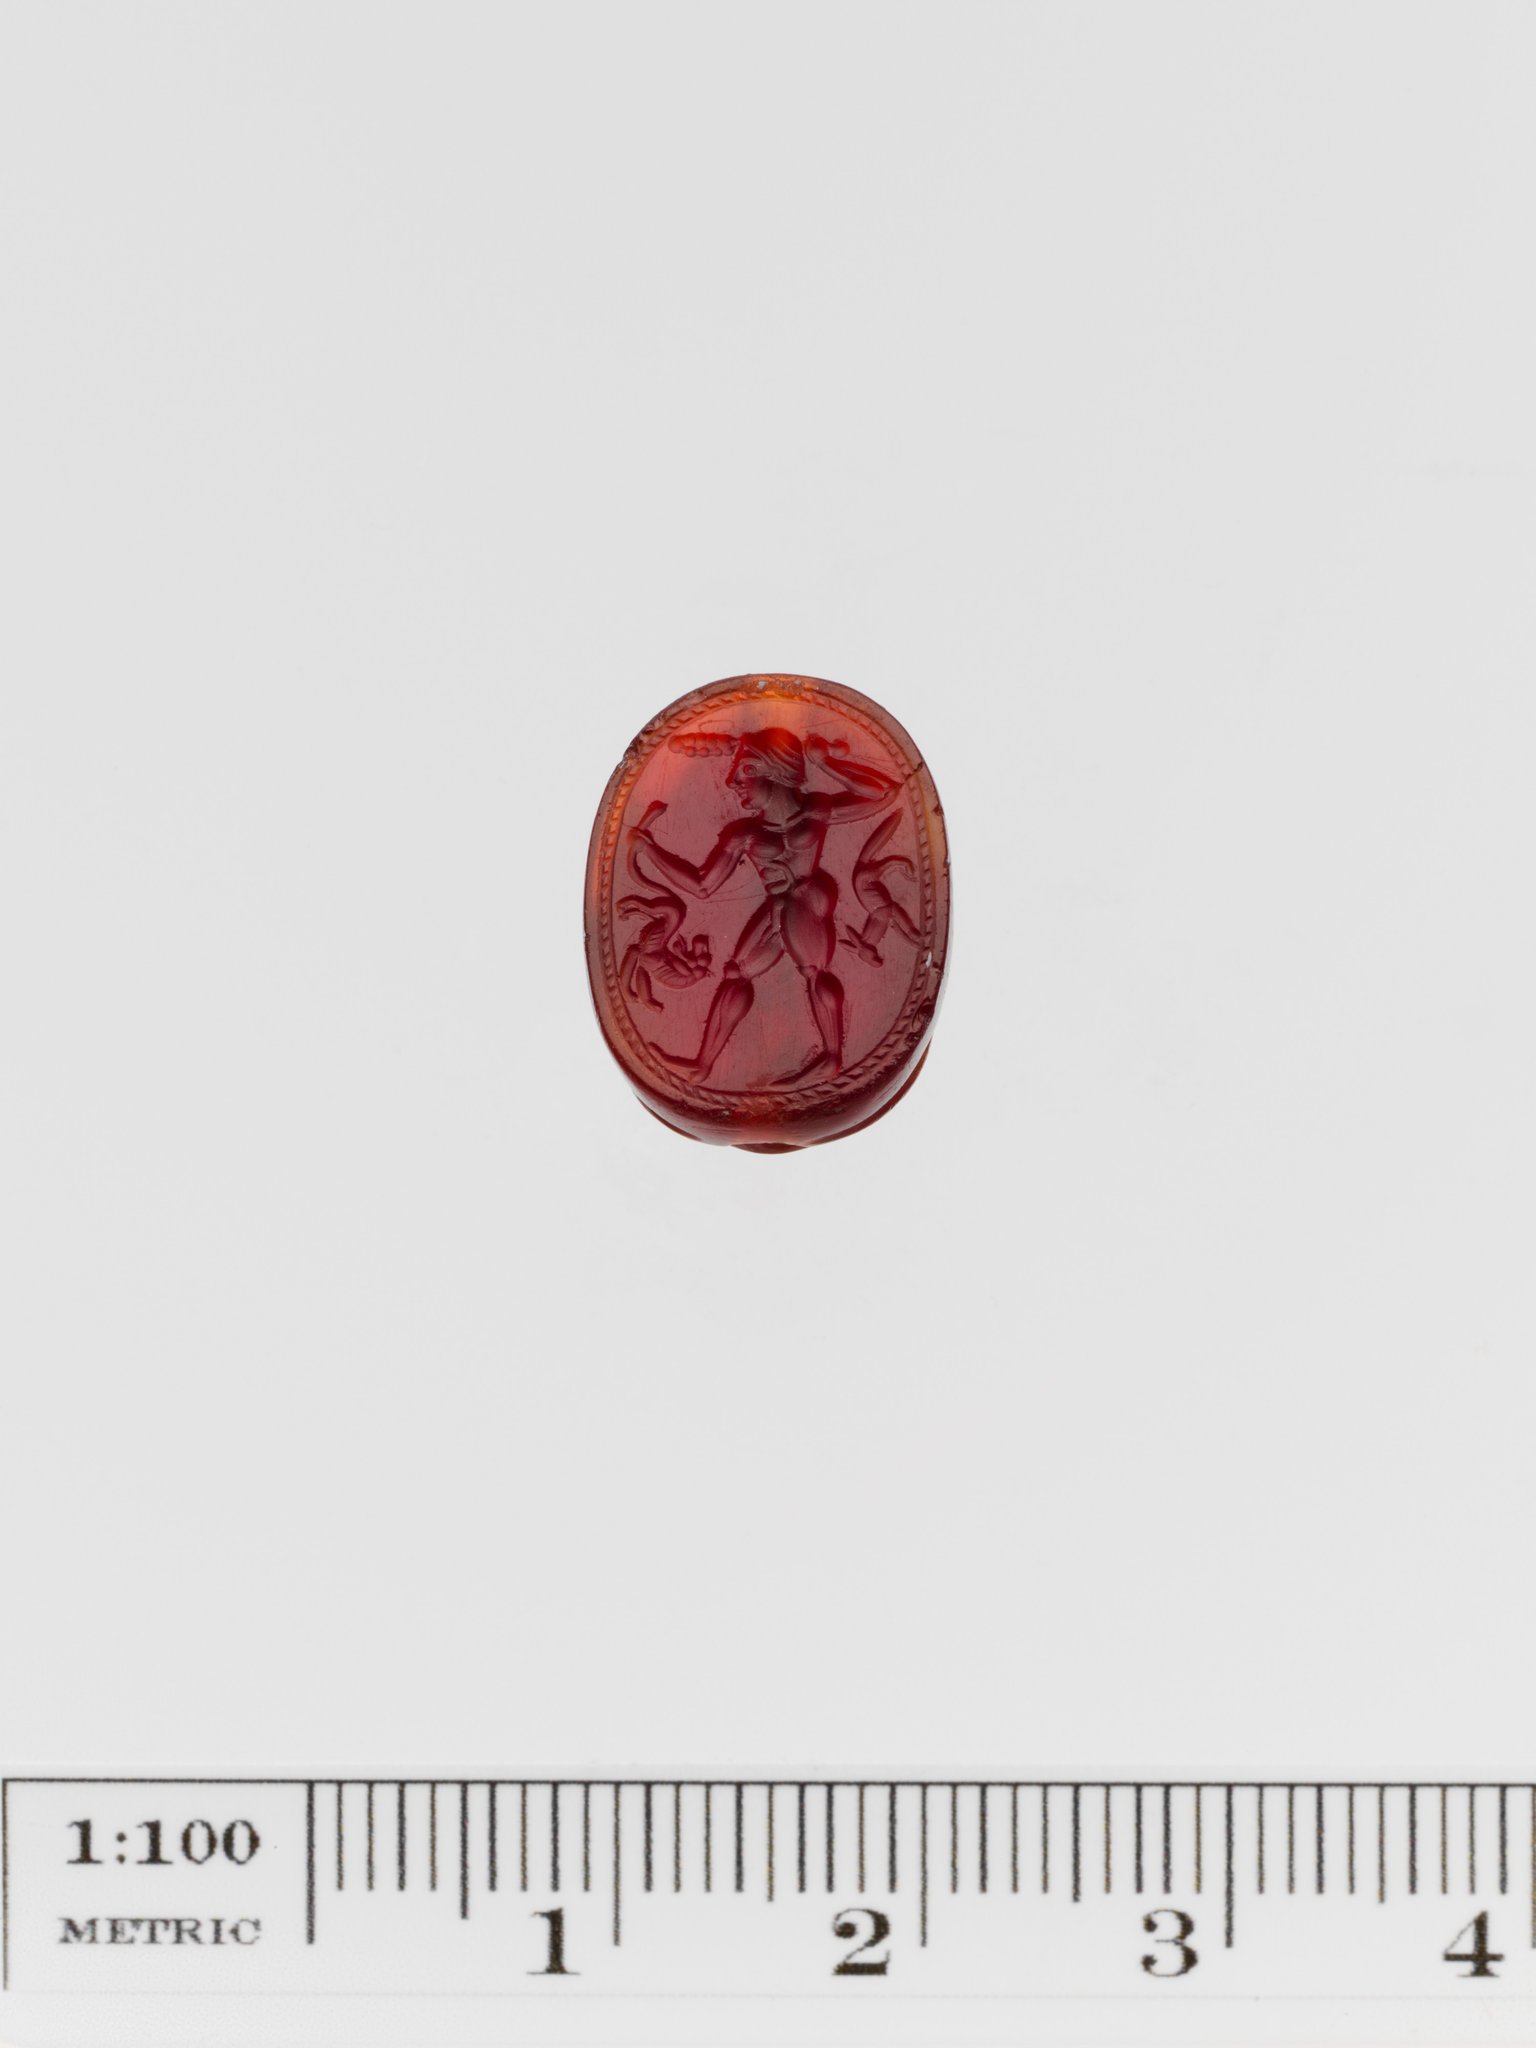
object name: scarab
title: Carnelian scarab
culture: greek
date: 500-468 BCE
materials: gemstone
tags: scarabs,lions